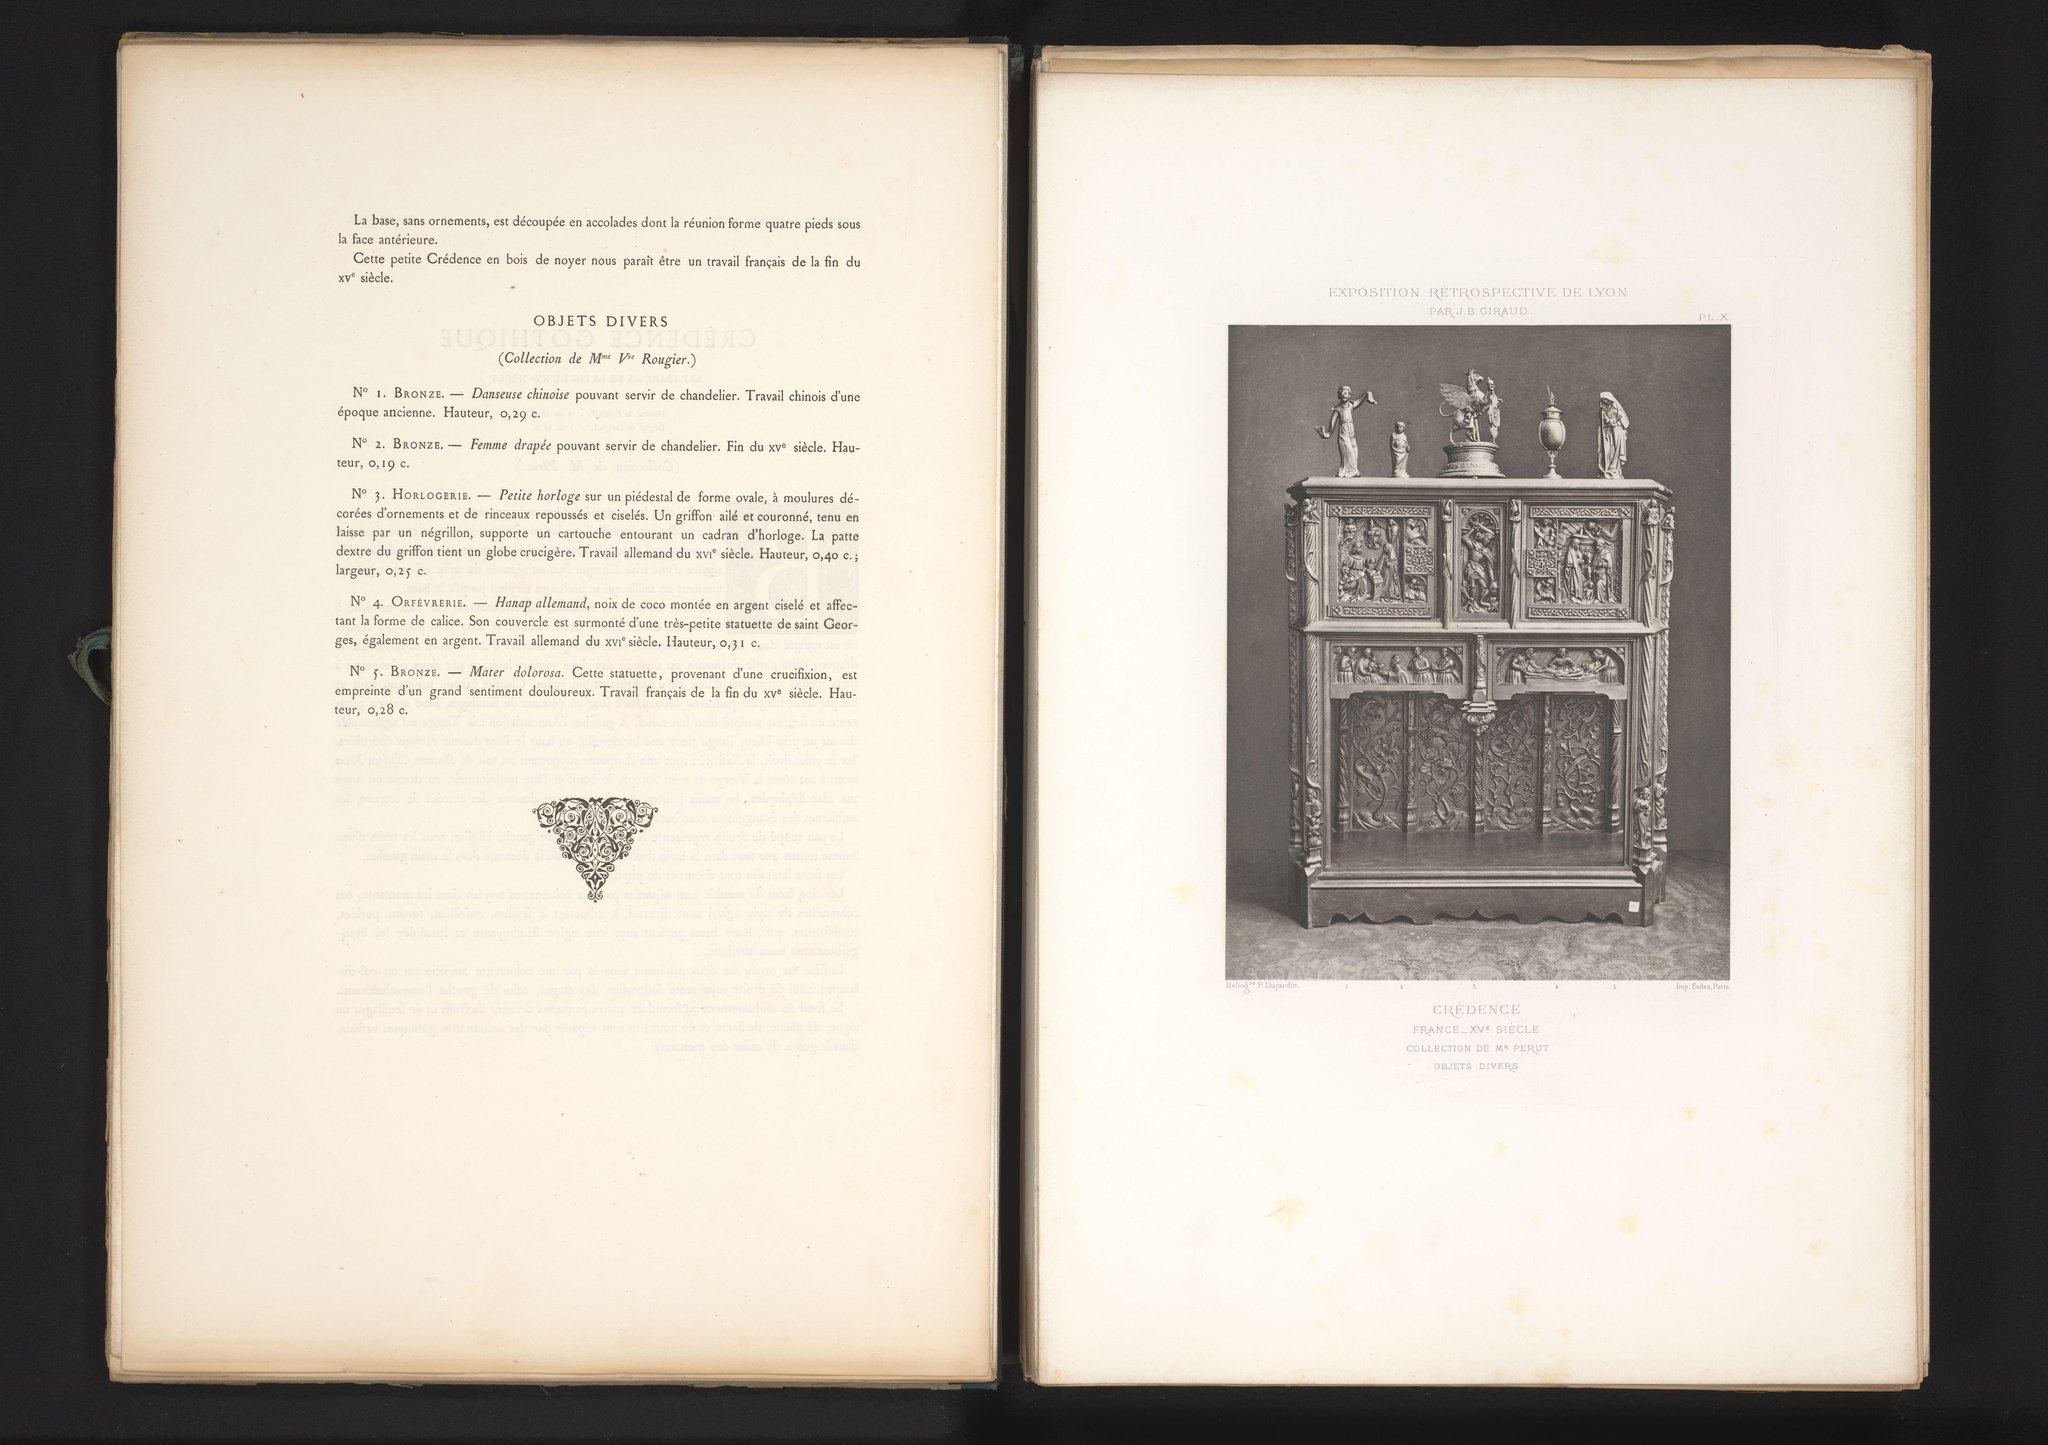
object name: photomechanical print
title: 15de-eeuws Frans dressoir van hout, op de Exposition Rétrospective van 1877 in Lyon, Frankrijk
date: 1877-1878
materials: paper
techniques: photoaquatint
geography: lyon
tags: ornamental cupboard (+ wood and other phytogenic material), lyon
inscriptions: number: ‘PL. X.’, inscription: ‘CRÉDENCE/ FRANCE_XVe SIÈCLE/ COLLECTION DE Mr PERUT./ OBJETS DIVERS.’, inscription: ‘EXPOSITION RÉTROSPECTIVE DE LYON/ PAR J. B. GIRAUD.’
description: Deze prent maakt deel uit van een omslag met 79 prenten op 54 bladen en 65 tekstbladen.